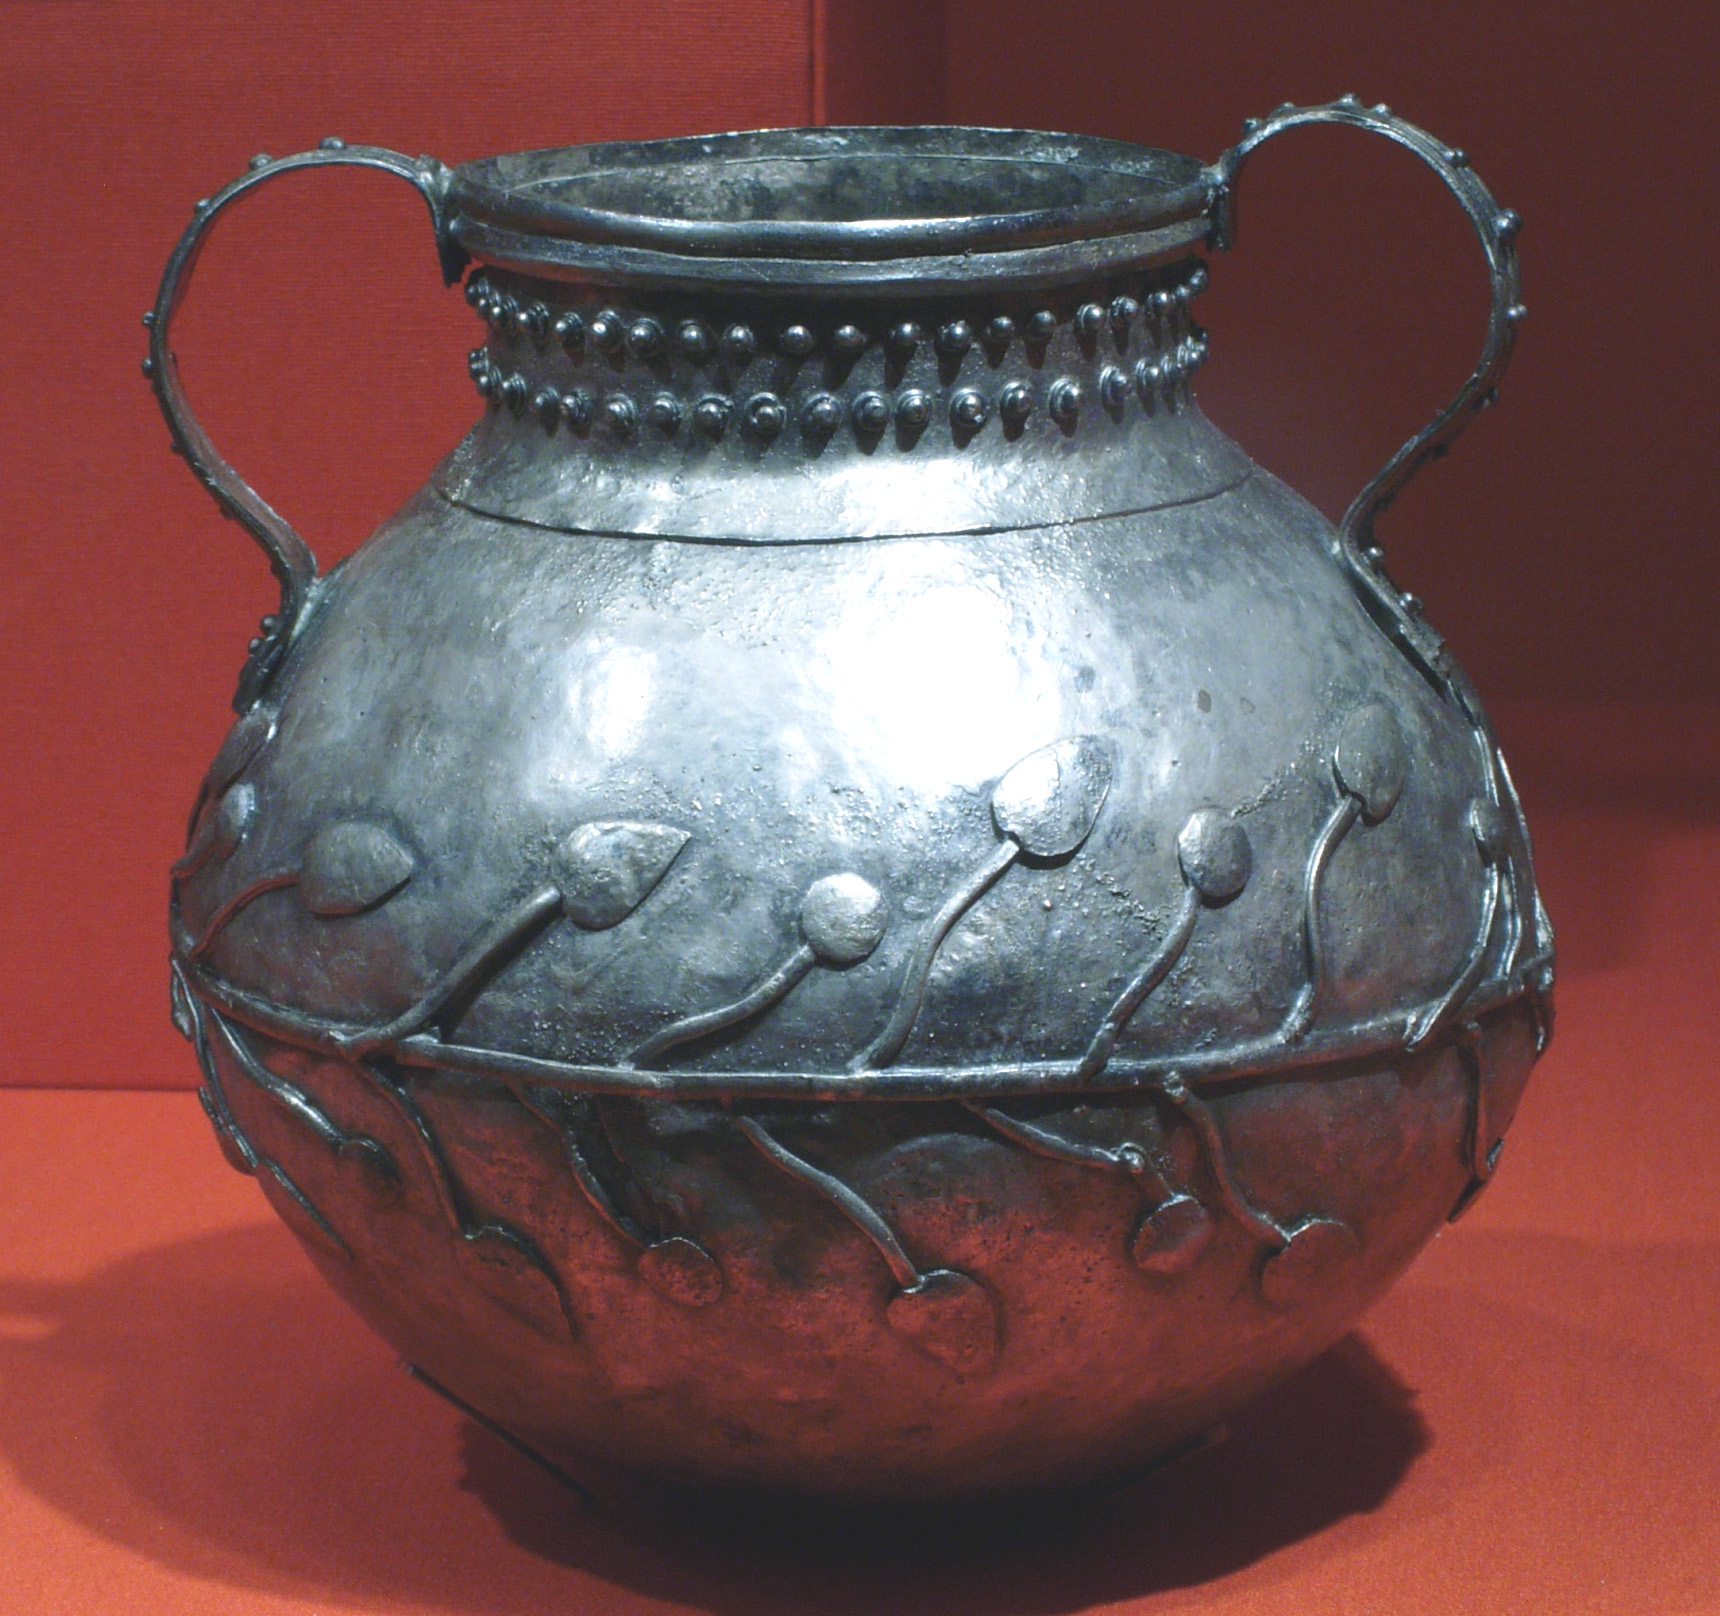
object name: vase, vine, leaf, berry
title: Vase with vine, leaves and berries on the body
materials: silver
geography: egypt